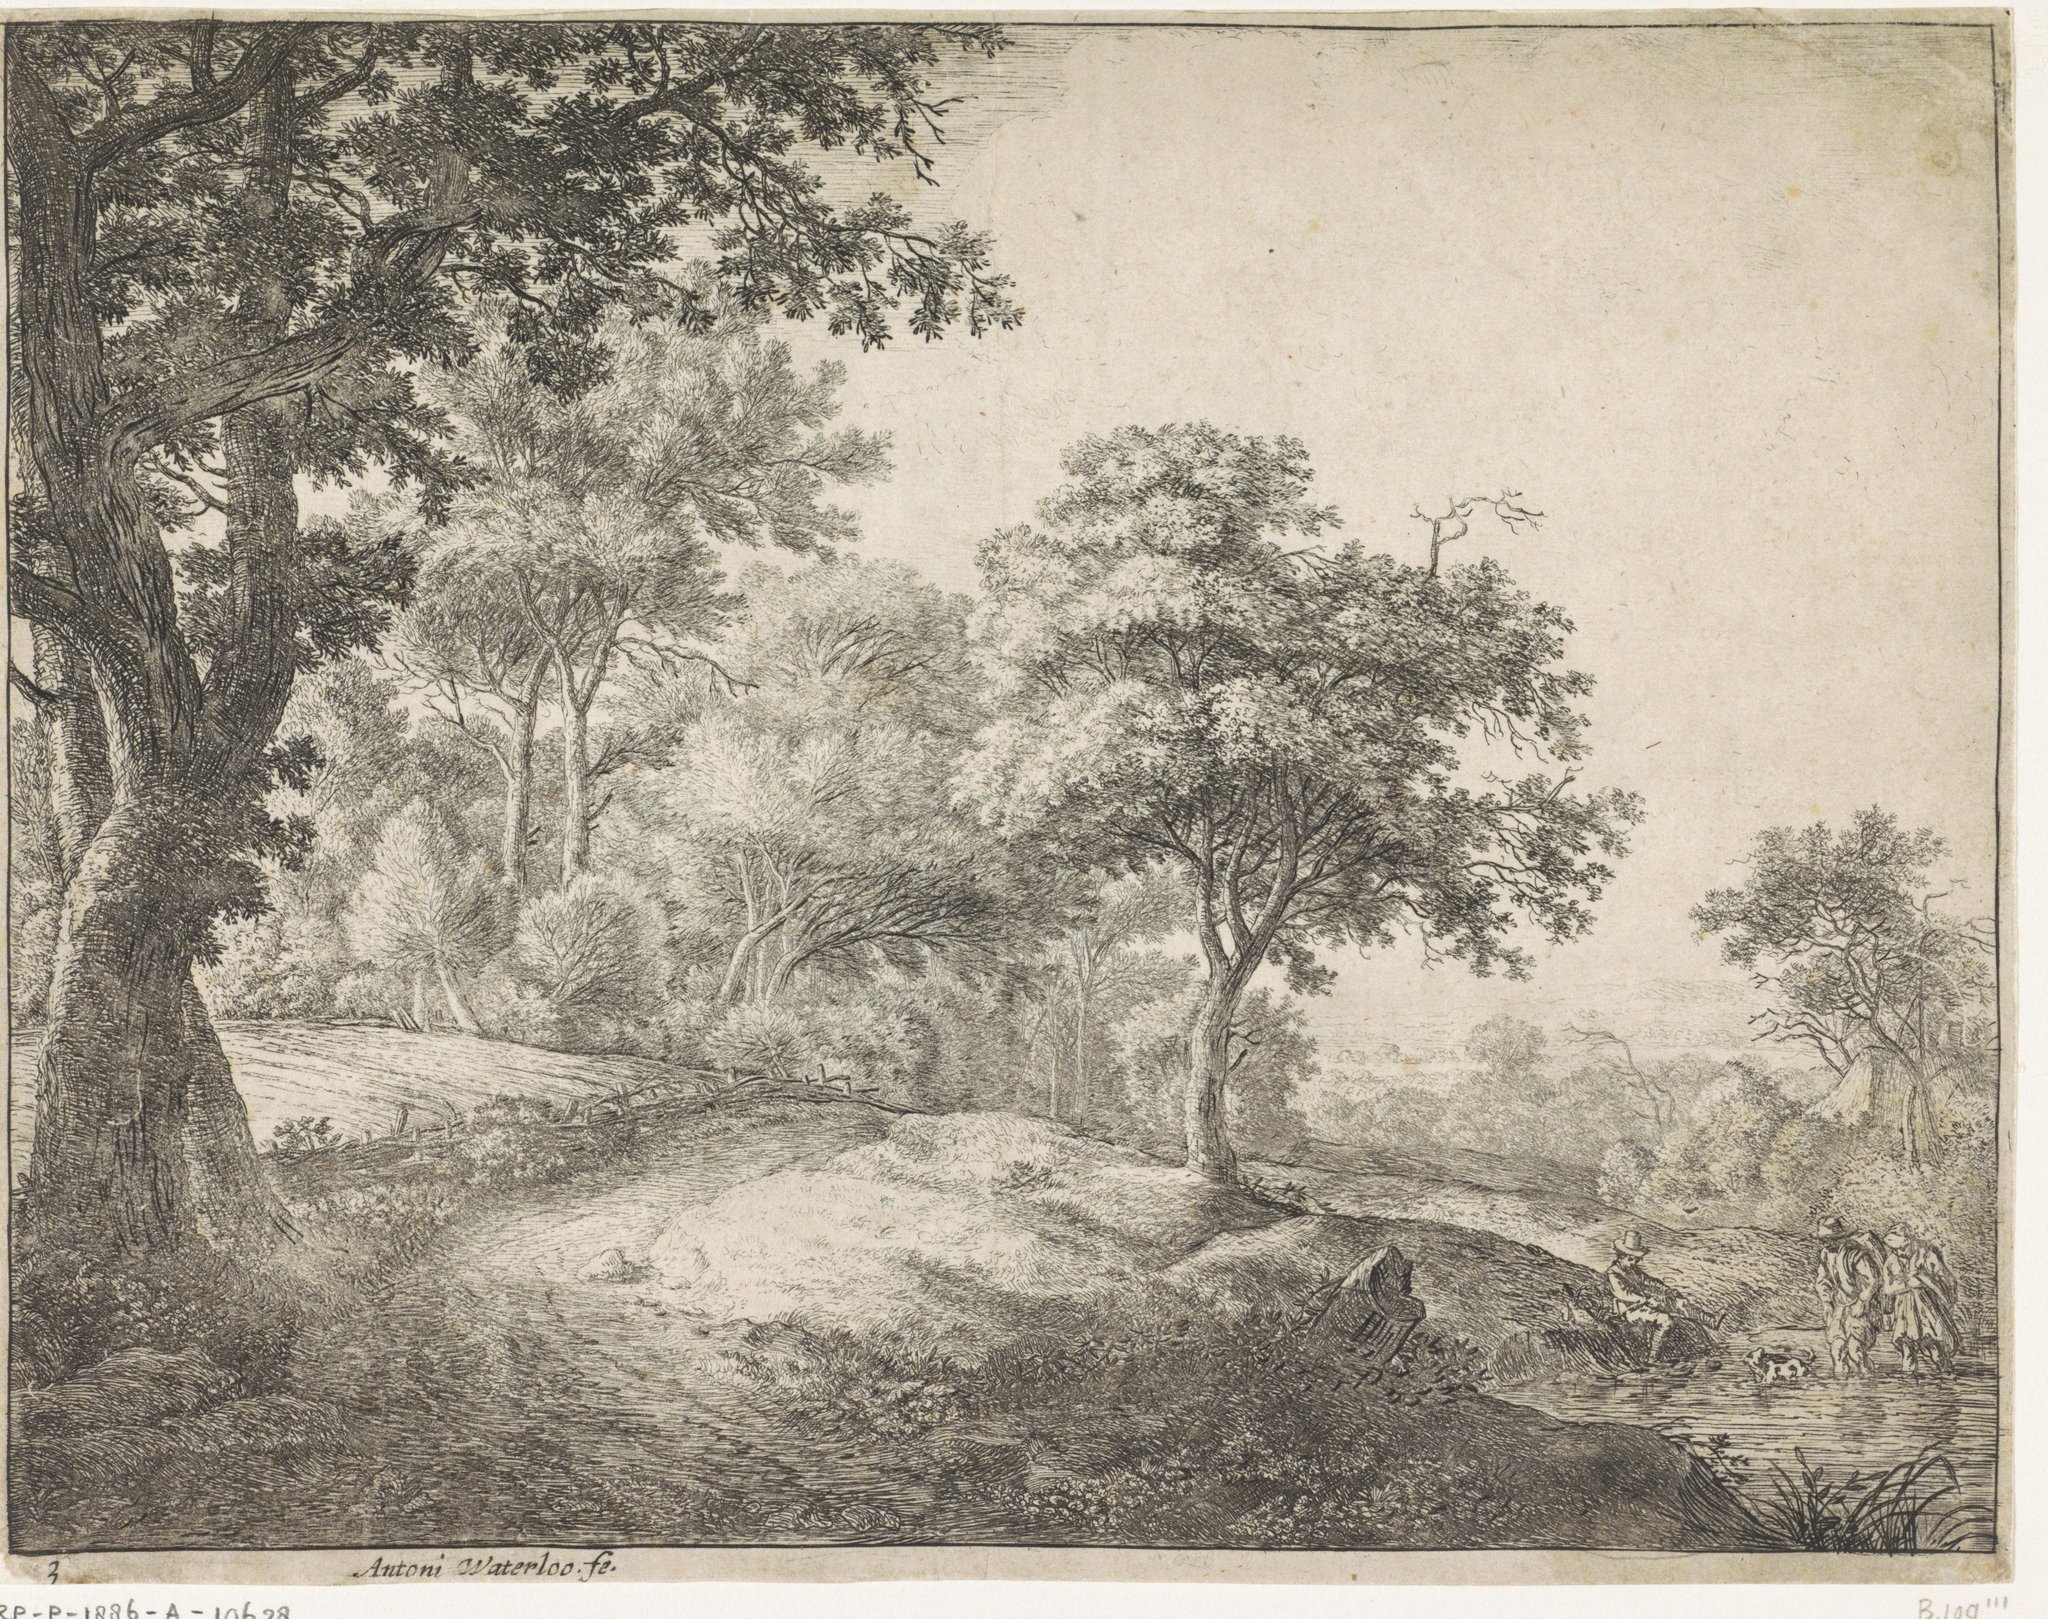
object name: print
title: Twee figuren door een beek wadend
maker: anthonie waterloo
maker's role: draughtsman, painter, print maker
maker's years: 1609-1690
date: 1630-1663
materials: paper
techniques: etching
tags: brook, forest path or lane, wading, paddling, dog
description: Links loopt een glooiend bospad. Rechts waden twee figuren met een hond door een beek. Op de oever zit een derde figuur. Achter hen is een huis te zien.